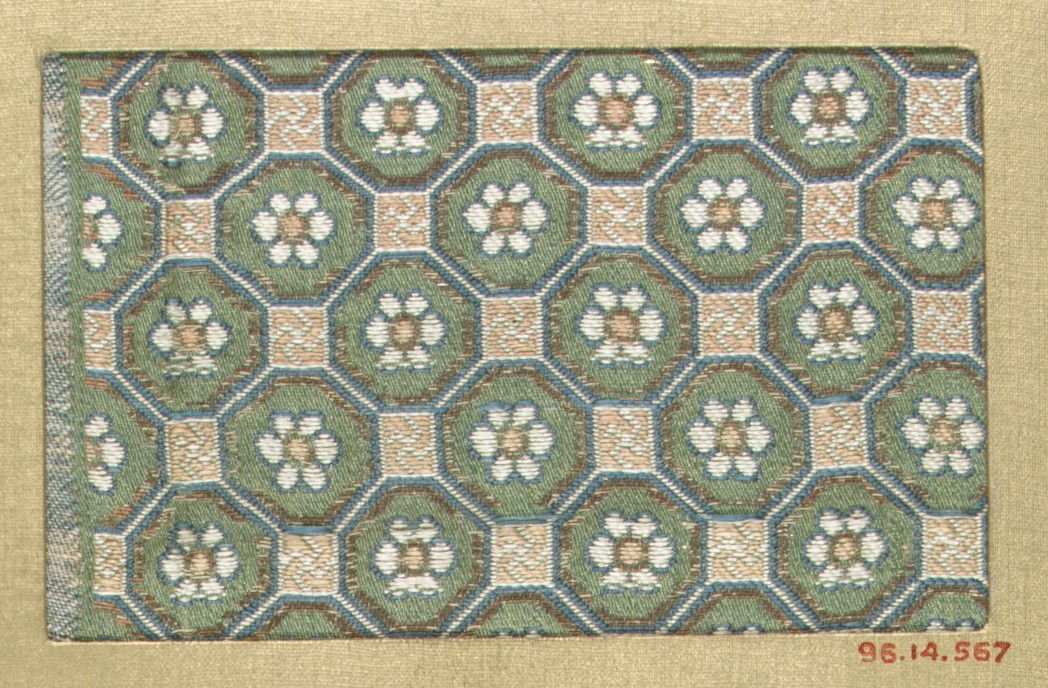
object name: piece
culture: japanese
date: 1701-1900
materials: silk